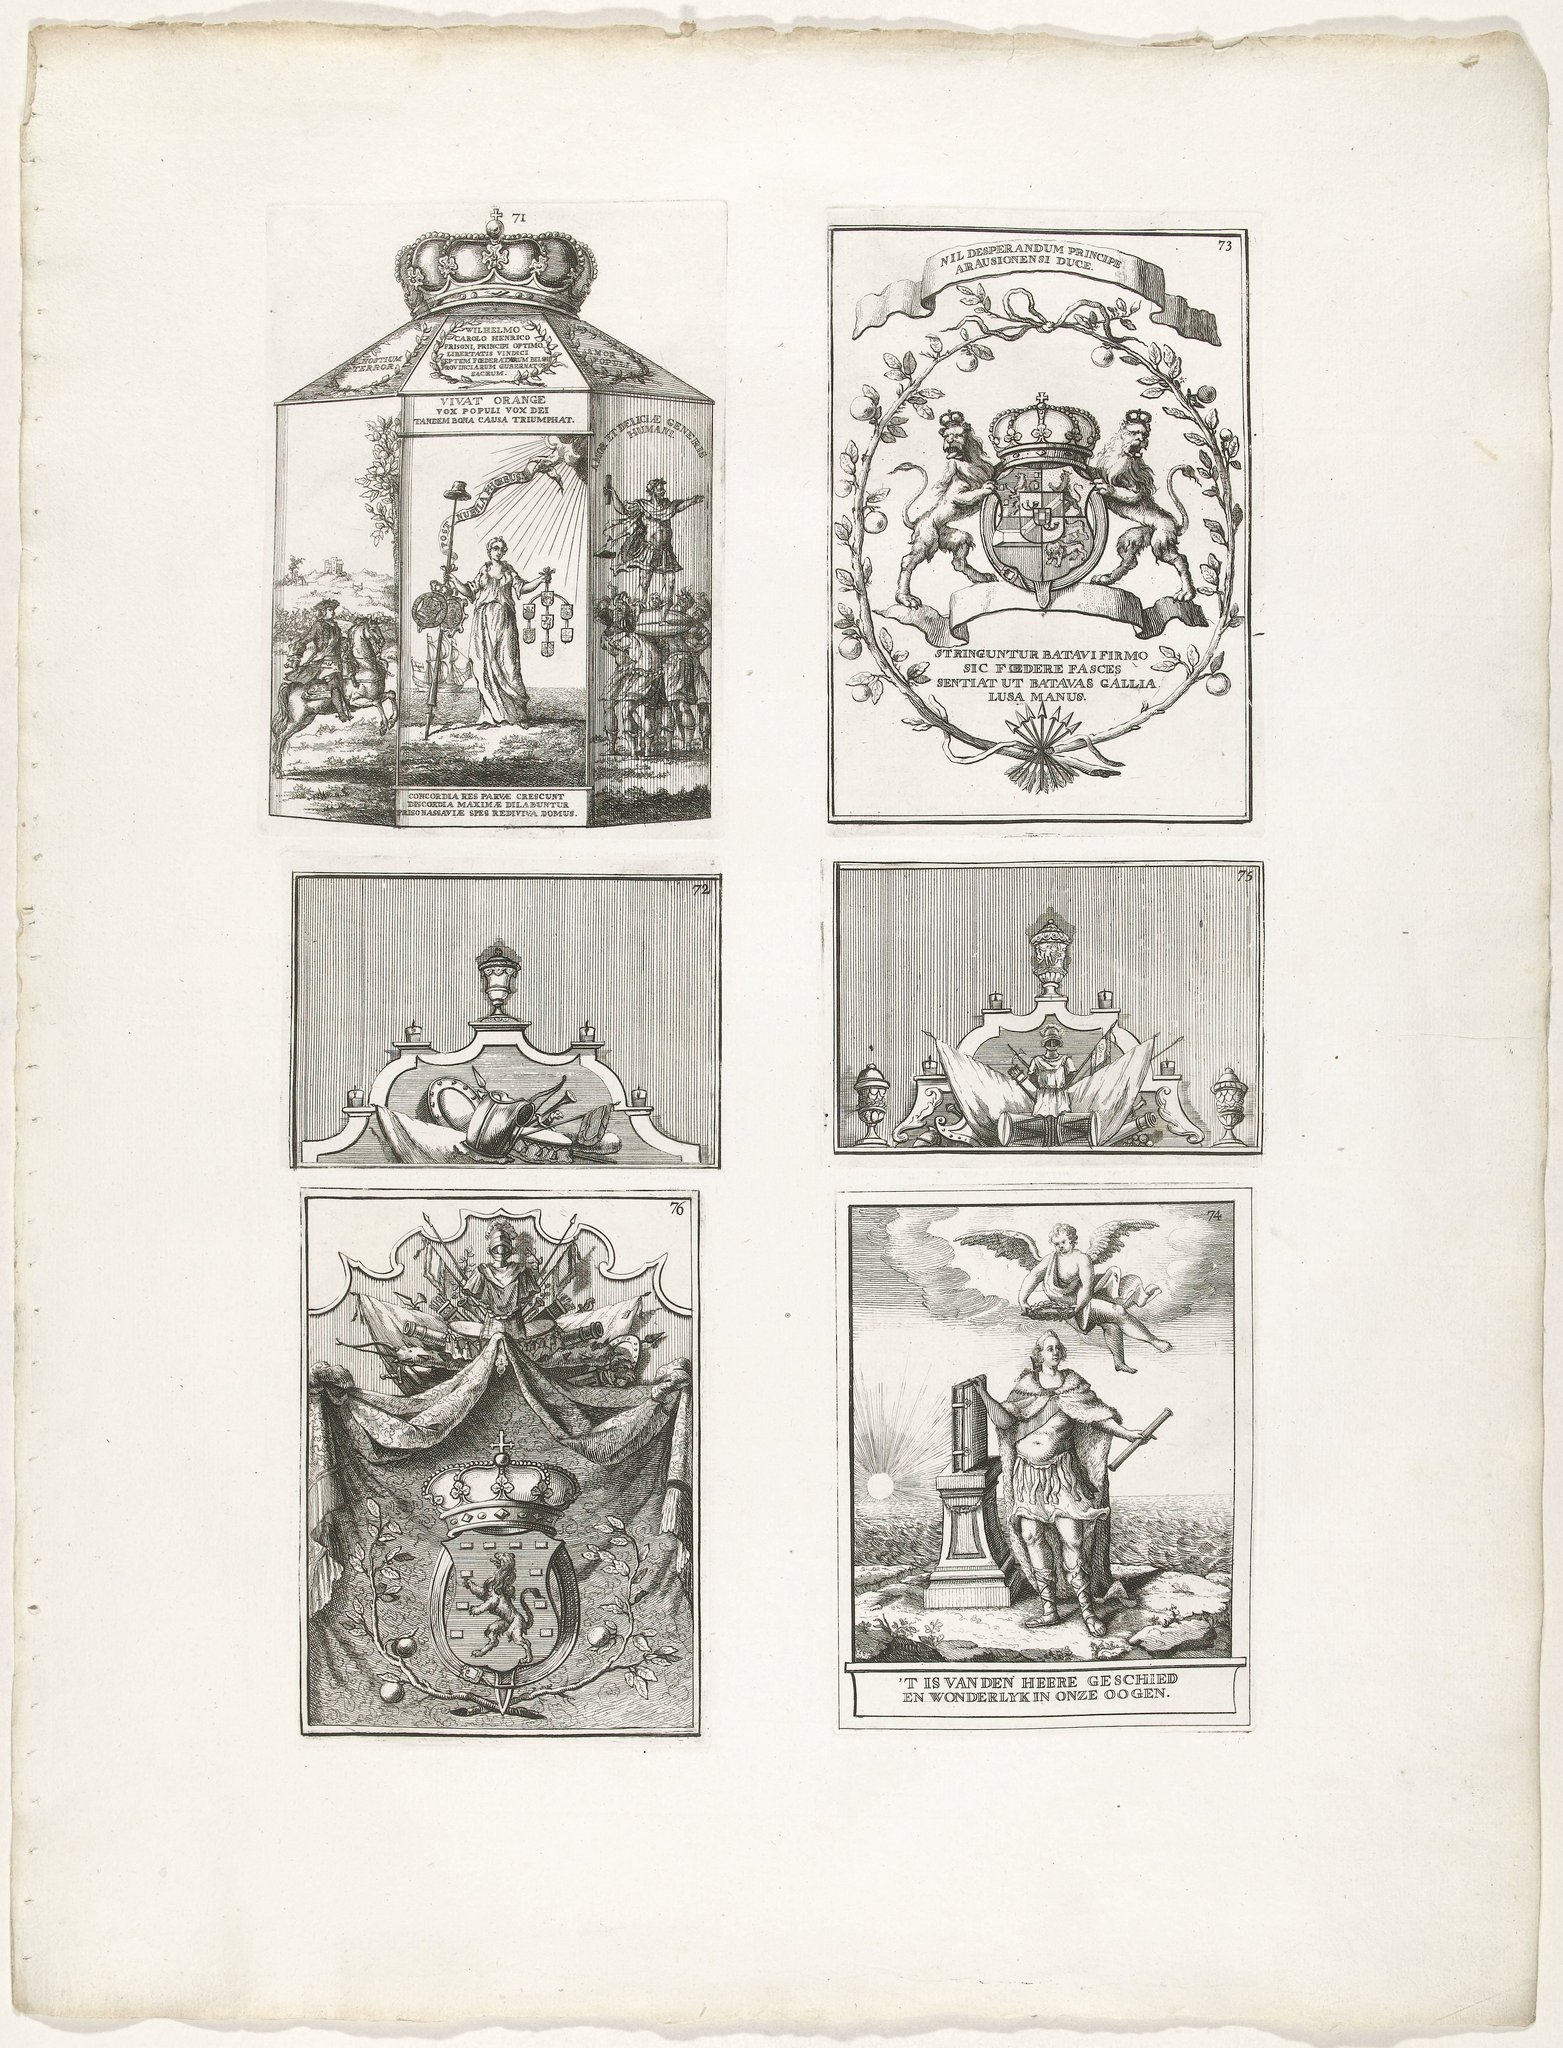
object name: print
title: Haga comitis illustrata; of het verheerlykt en verligt 's Gravenhage bestaende in eene (...) verzameling van 116 (...) in het koper gebragte afbeeldingen, der (...) geillumineerd geweest zynde decoratien en zinnebeelden (...) ter geleegenheid der (...) verkiezinge, proclamatie & installatie van Z.D.H. Willem Carel Hendrik Friso, Prince van Oranje & Nassau, enz. tot Stadhouder (...) den 3 & 15 May 1747 : opgehelderd door een (...) beschryving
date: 1751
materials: paper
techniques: engraving, etching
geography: the hague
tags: the hague, willem iv (prins van oranje-nassau), decoration and illumination of streets, squares, etc. (~ triumphal entry, etc.)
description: Blad met de decoraties aangeduid met de cijfers 71-76, opgehangen aan de huizen van inwoners van Den Haag. Los blad oorspronkelijk onderdeel van het plaatwerk Haga comitis illustrata uit 1751 met de versieringen opgesteld te Den Haag tijdens de feestelijkheden rond de installatie van prins Willem IV als stadhouder van Holland en West-Friesland op 3 en 15 mei 1747.